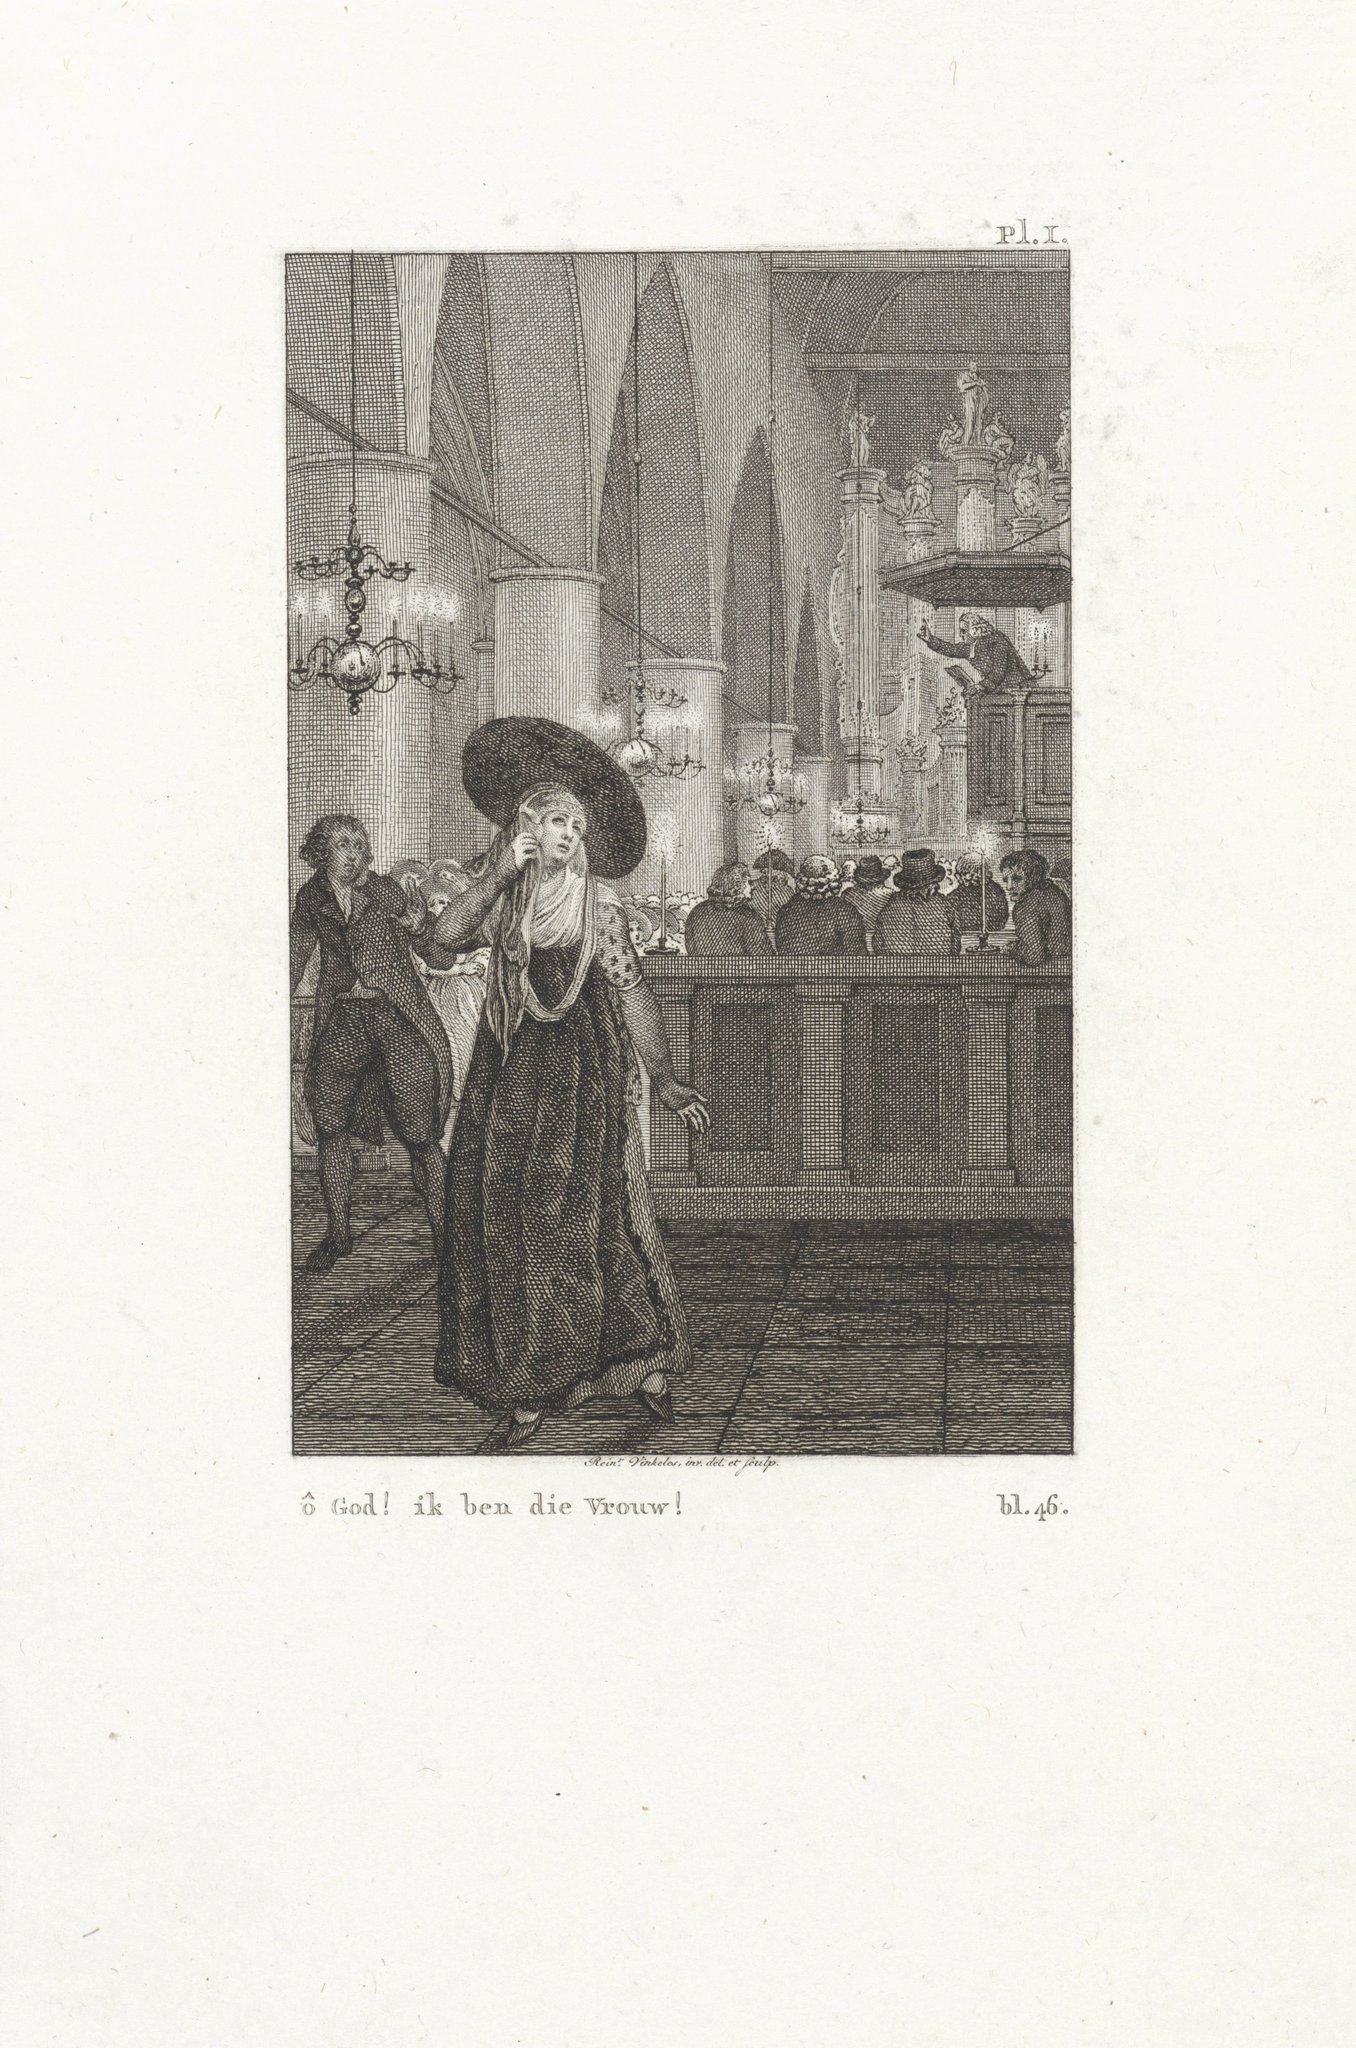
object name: print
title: Rinske verlaat verdrietig de kerk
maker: reinier vinkeles (i)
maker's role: draughtsman, print maker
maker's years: 1741-1816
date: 1804-1805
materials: paper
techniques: engraving, etching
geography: amsterdam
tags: taking leave (+ variant), interior of church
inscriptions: collector's mark: Lugt 240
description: Proefdruk van een prent die ook gebruikt is als illustratie in: Loosjes, Adriaan Pietersz. Zedelijke Verhaalen. Haarlem: Adriaan Loosjes, 1804-1805. Tweede druk Haarlem: Adriaan Loosjes, 1815.